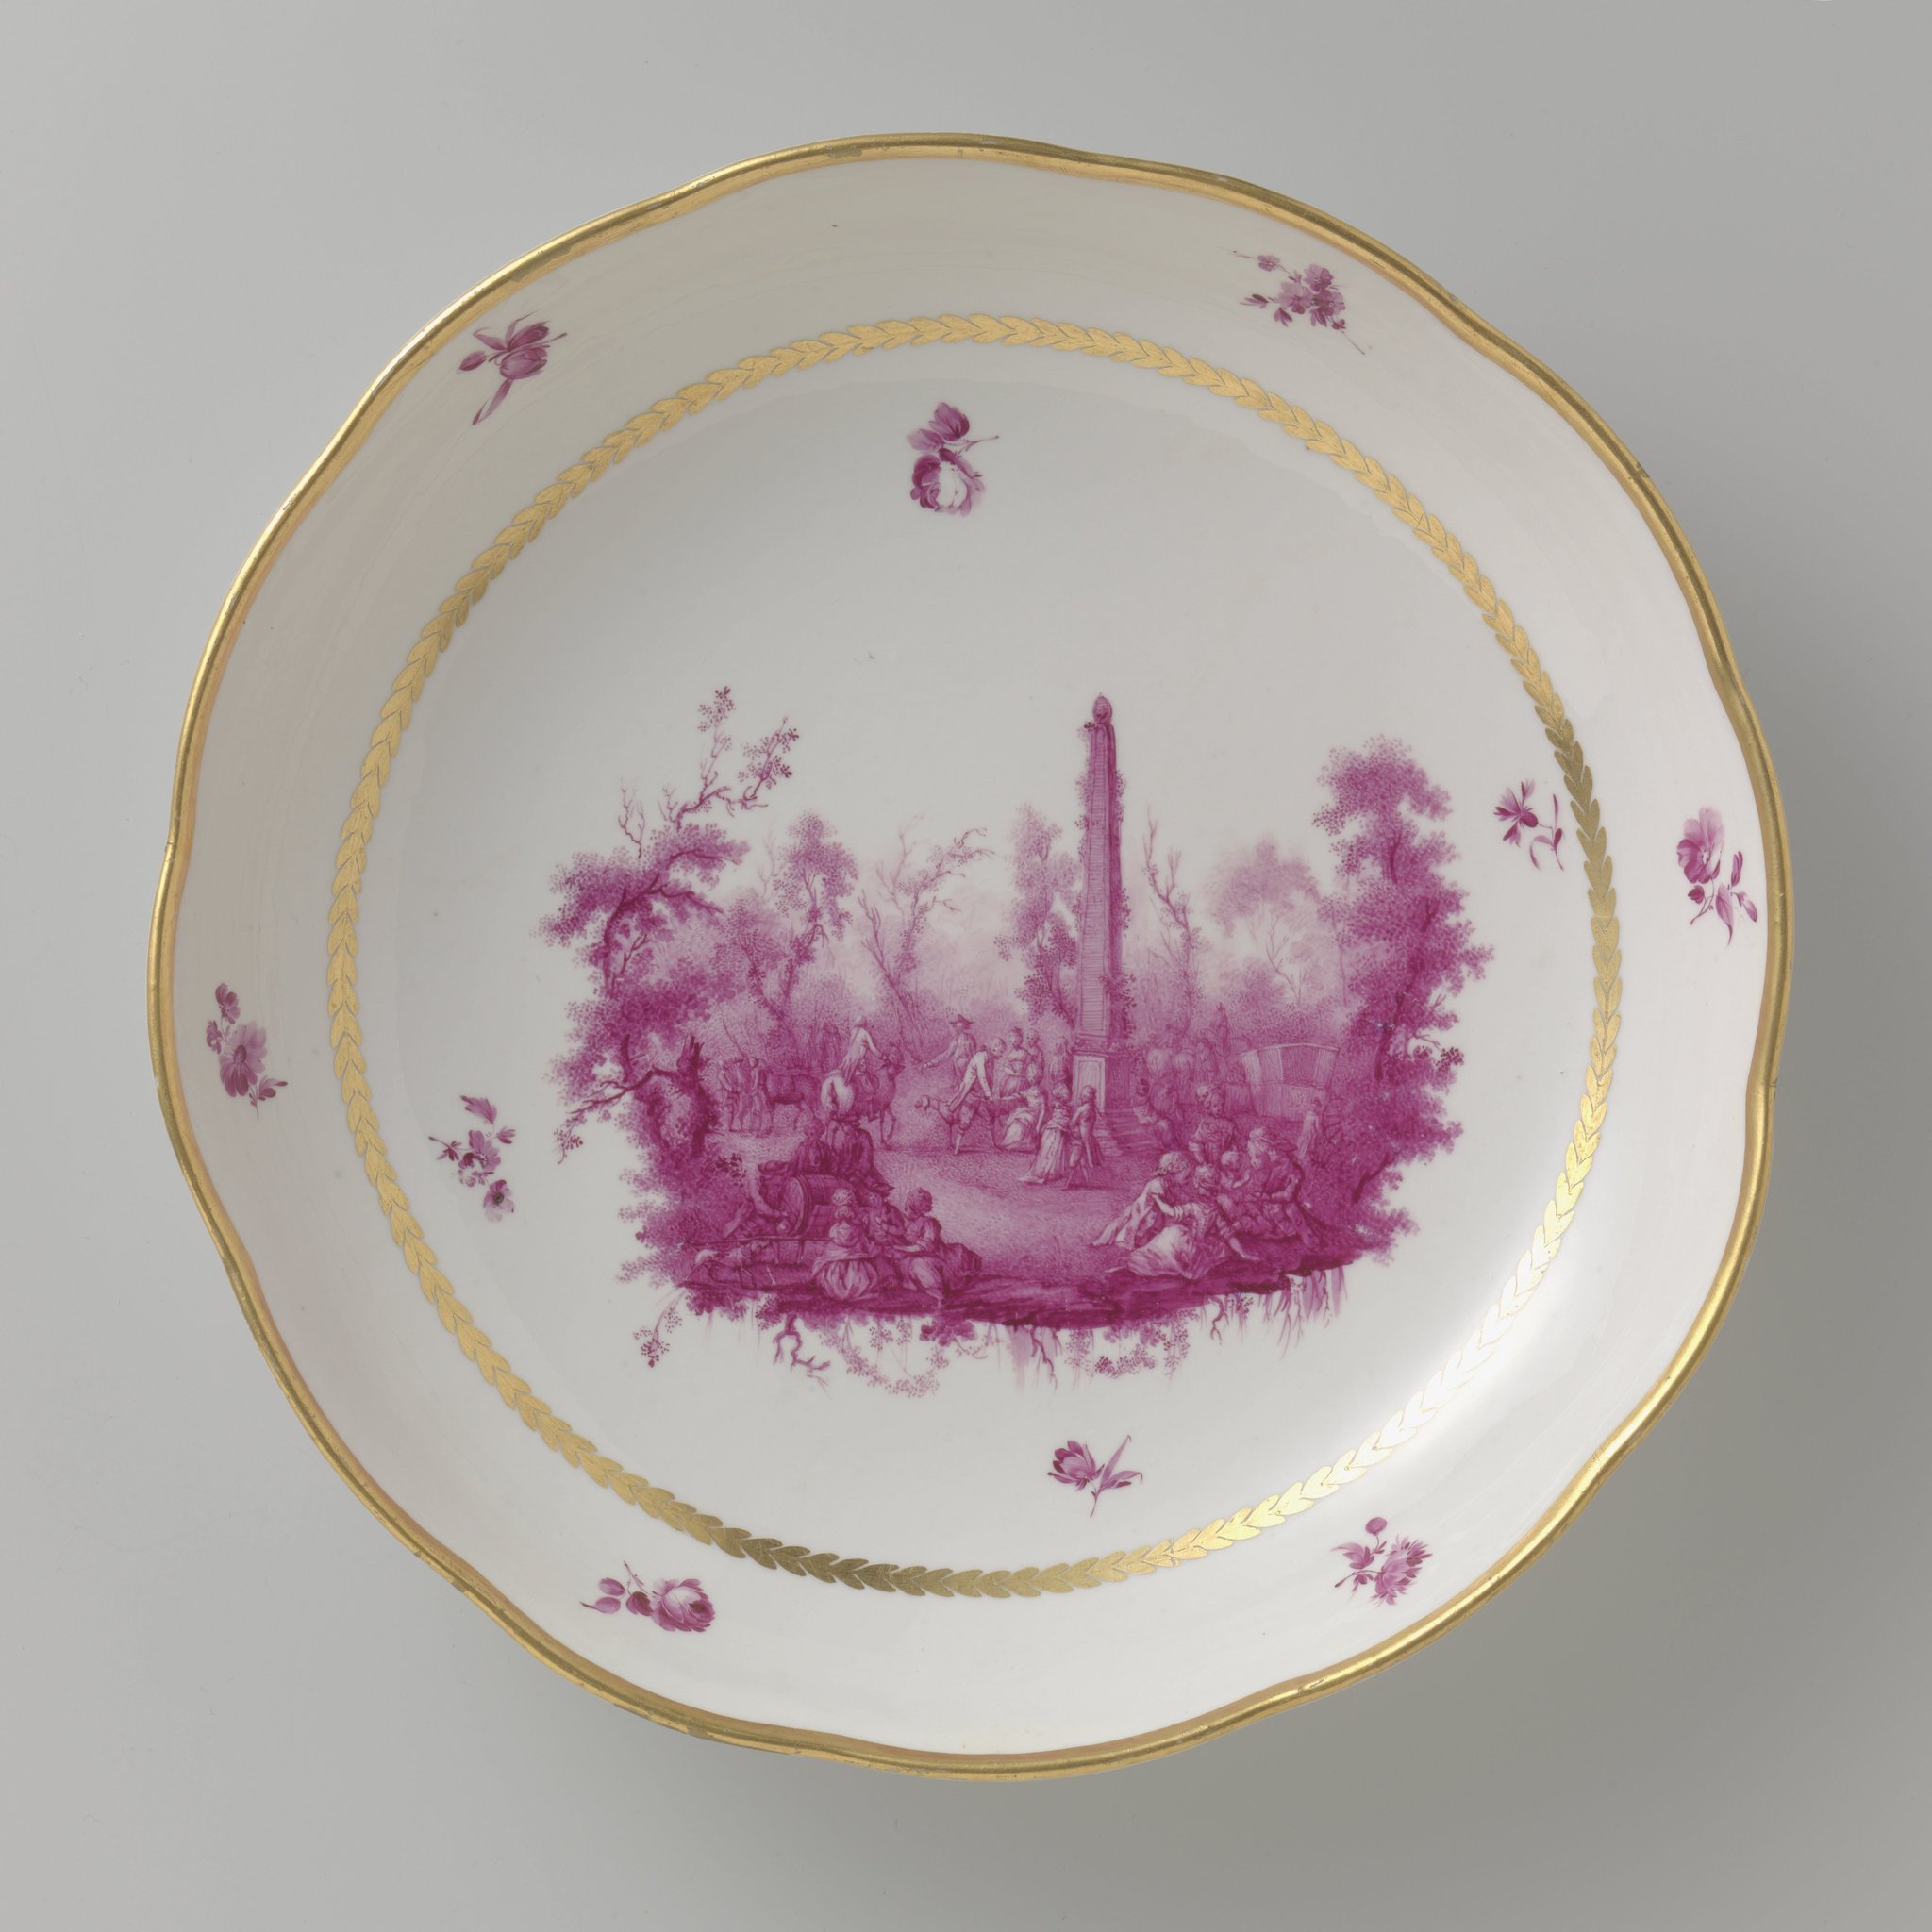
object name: dish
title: Schaal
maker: fidelle duvivier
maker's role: porseleinschilder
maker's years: 1740-1817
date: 1778-1782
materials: porcelain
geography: loosdrecht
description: Two dishes. Porcelain. Loosdrecht, c. 1778 - 1782. Factory of Joannes de Mol.